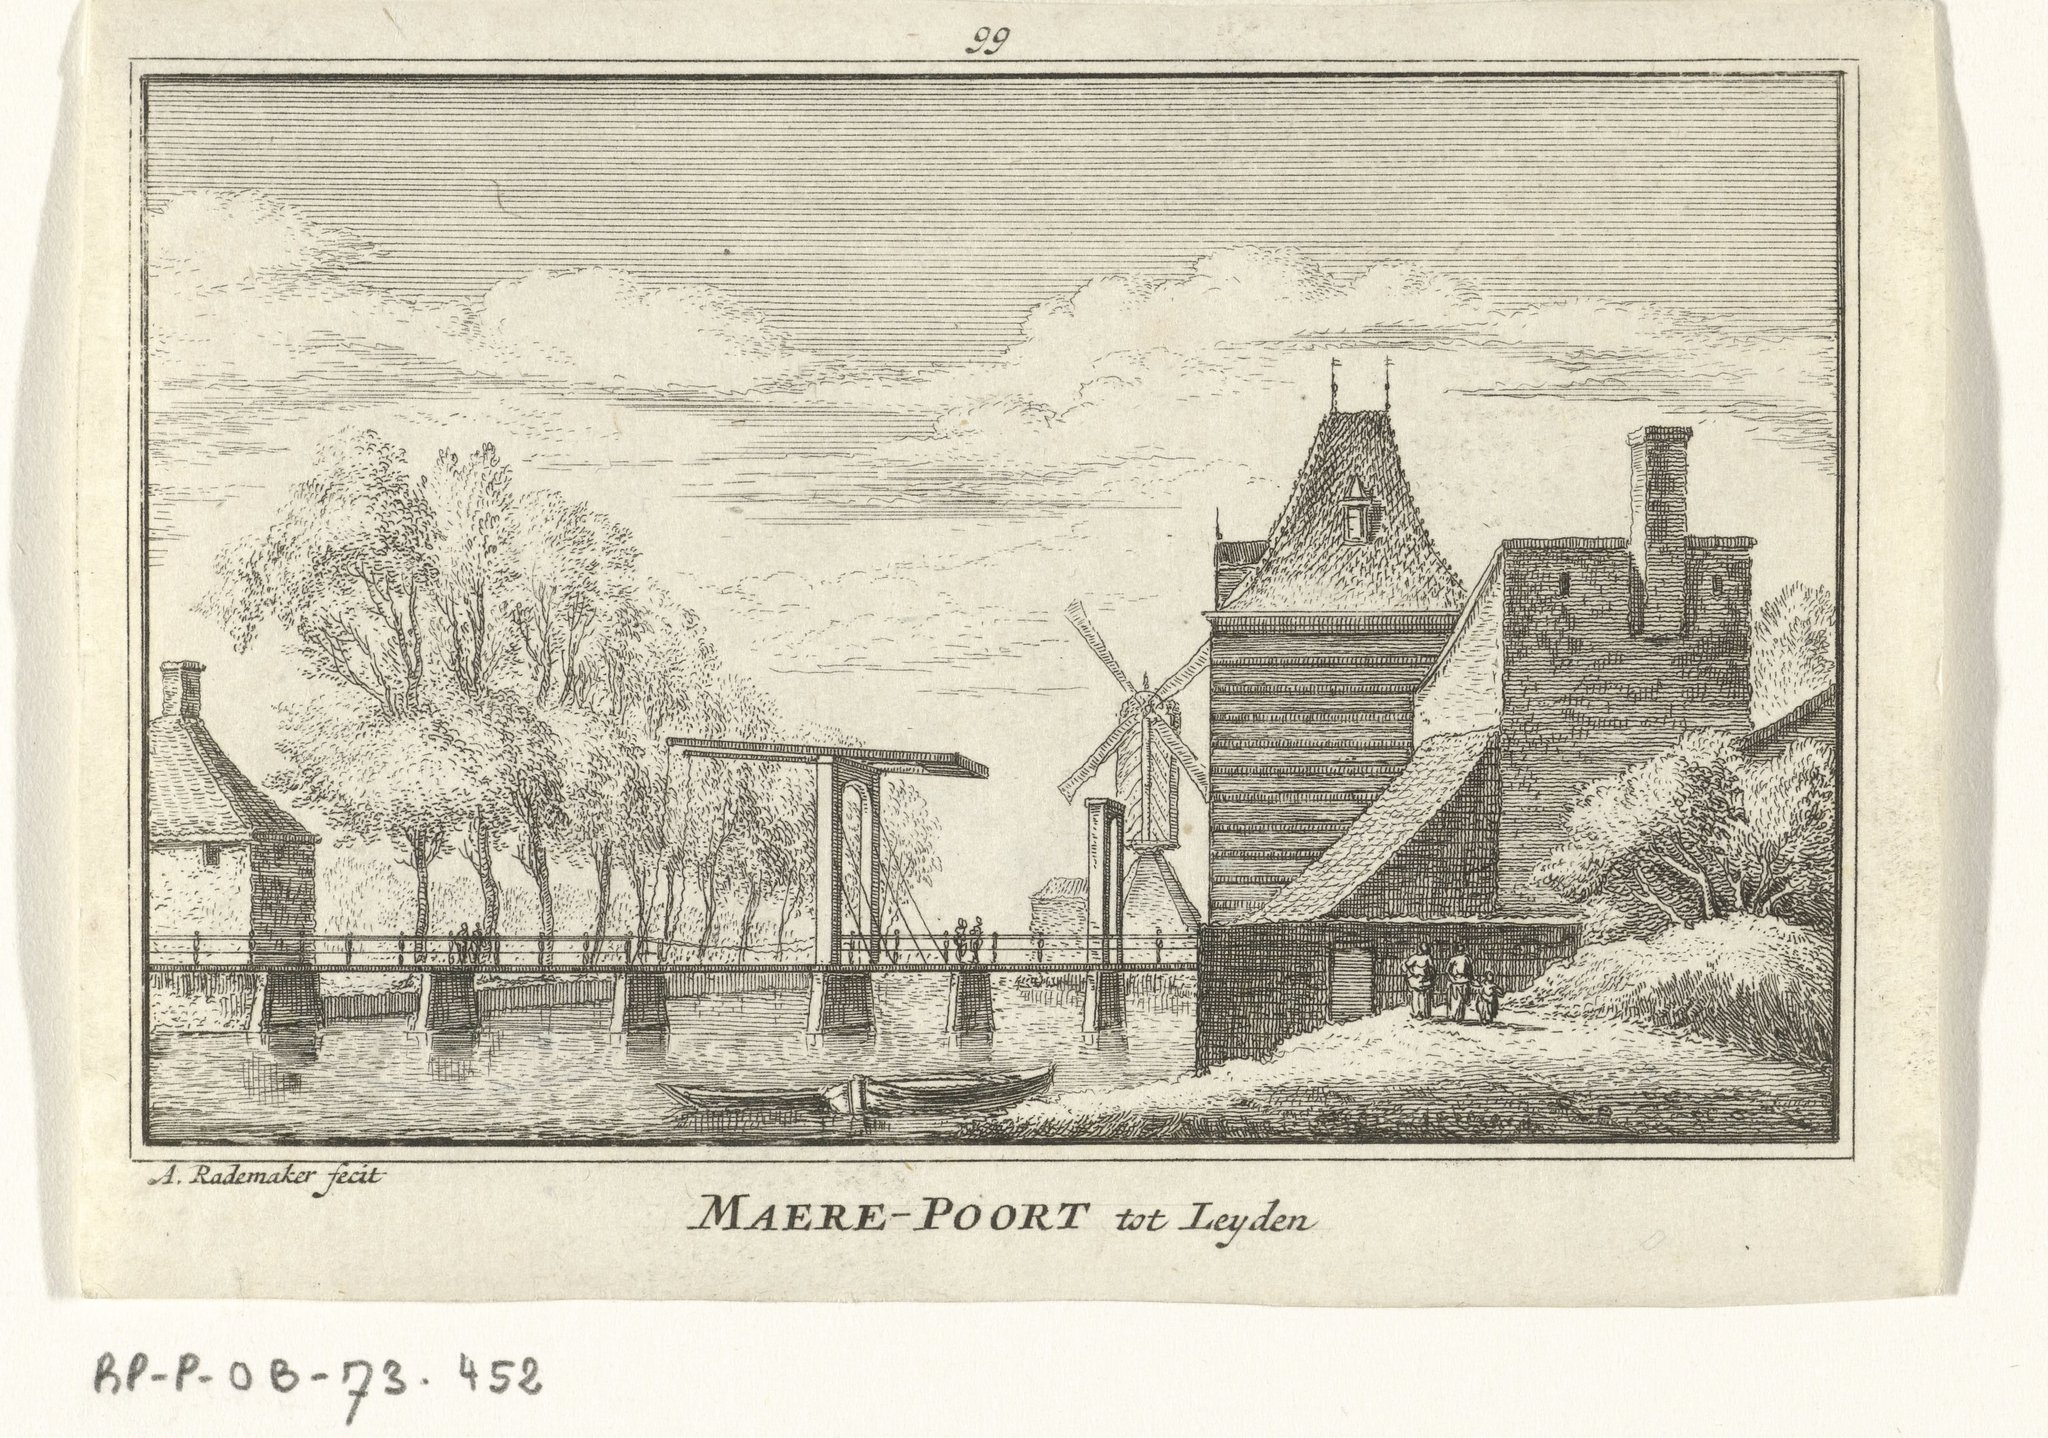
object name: print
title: Maere-Poort tot Leyden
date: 1727-1733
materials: paper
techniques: etching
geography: amsterdam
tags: bridge, windmill, city-gate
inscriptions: collector's mark: Lugt 2228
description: Illustratie uit: Abraham Rademaker, Matthaeus Brouërius van Niedek, Isaac Le Long, Kabinet van Nederlandsche en Kleefsche outheden en (...) voorname stads- en landgebouwen, Willem Barents en Antoni Schoonenburg: Amsterdam, 1727-1733, ill. nr. 99.